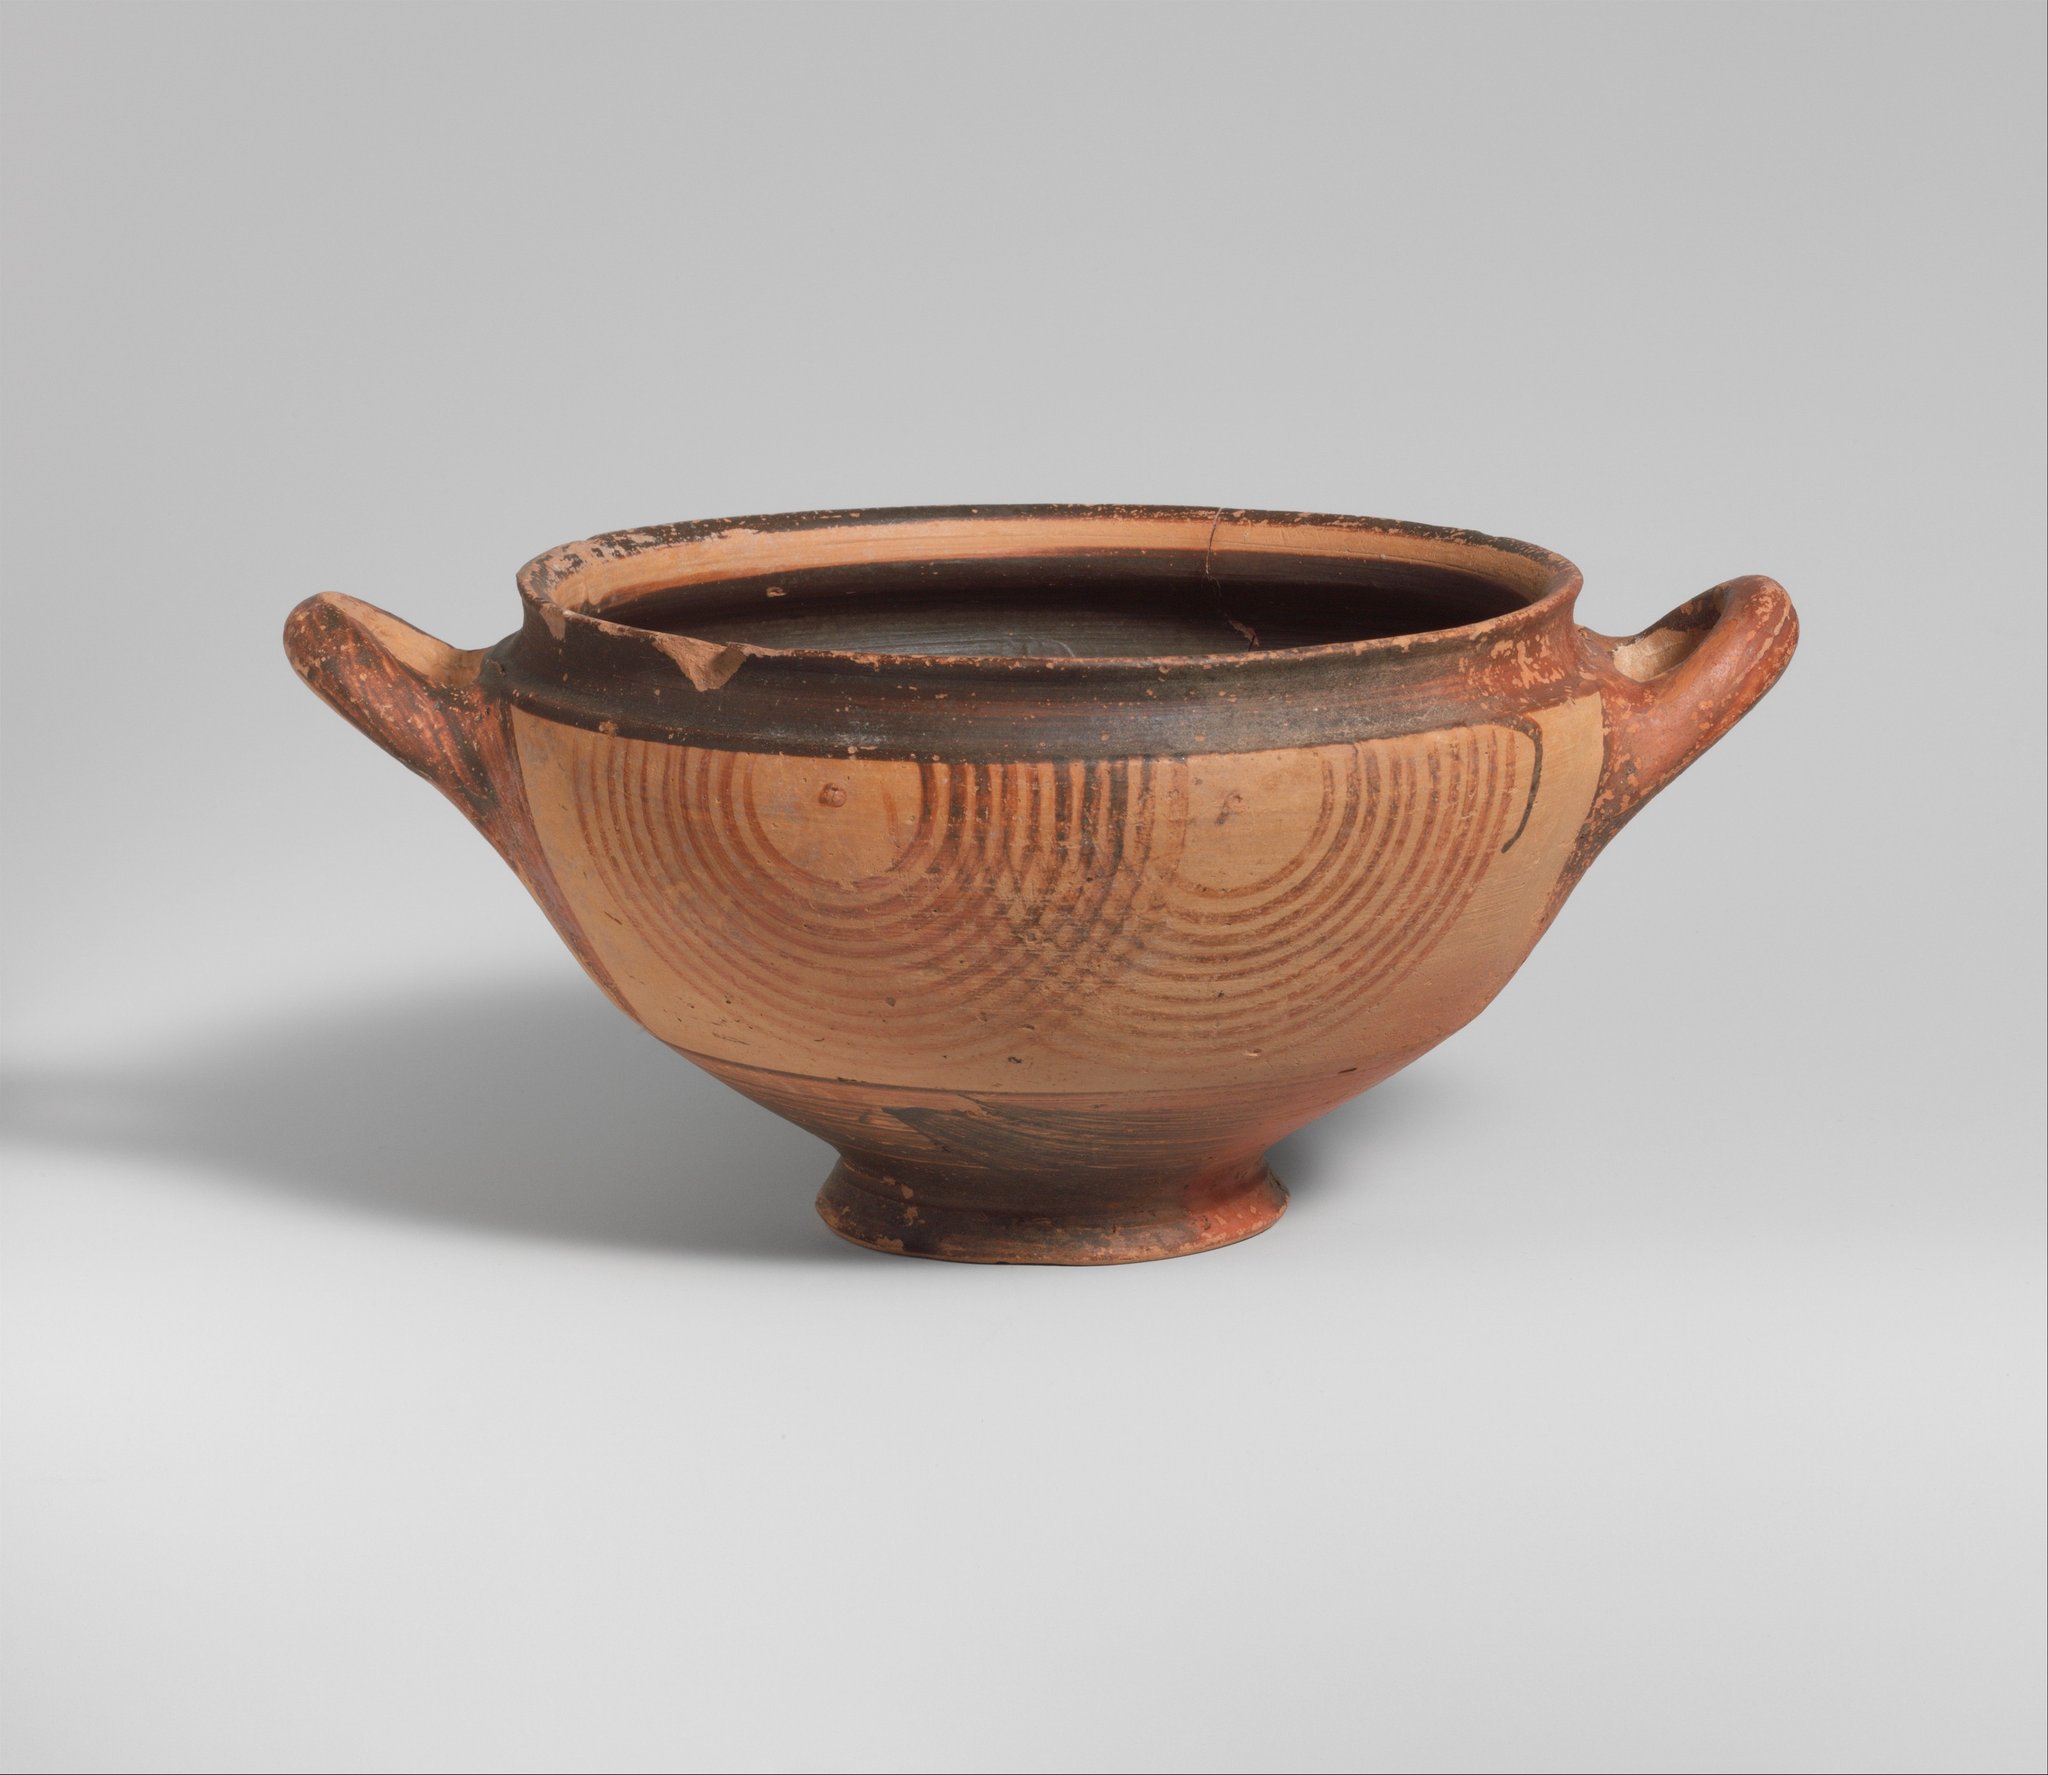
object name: skyphos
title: Terracotta skyphos (deep drinking cup)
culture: greek, euboean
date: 800-751 BCE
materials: terracotta